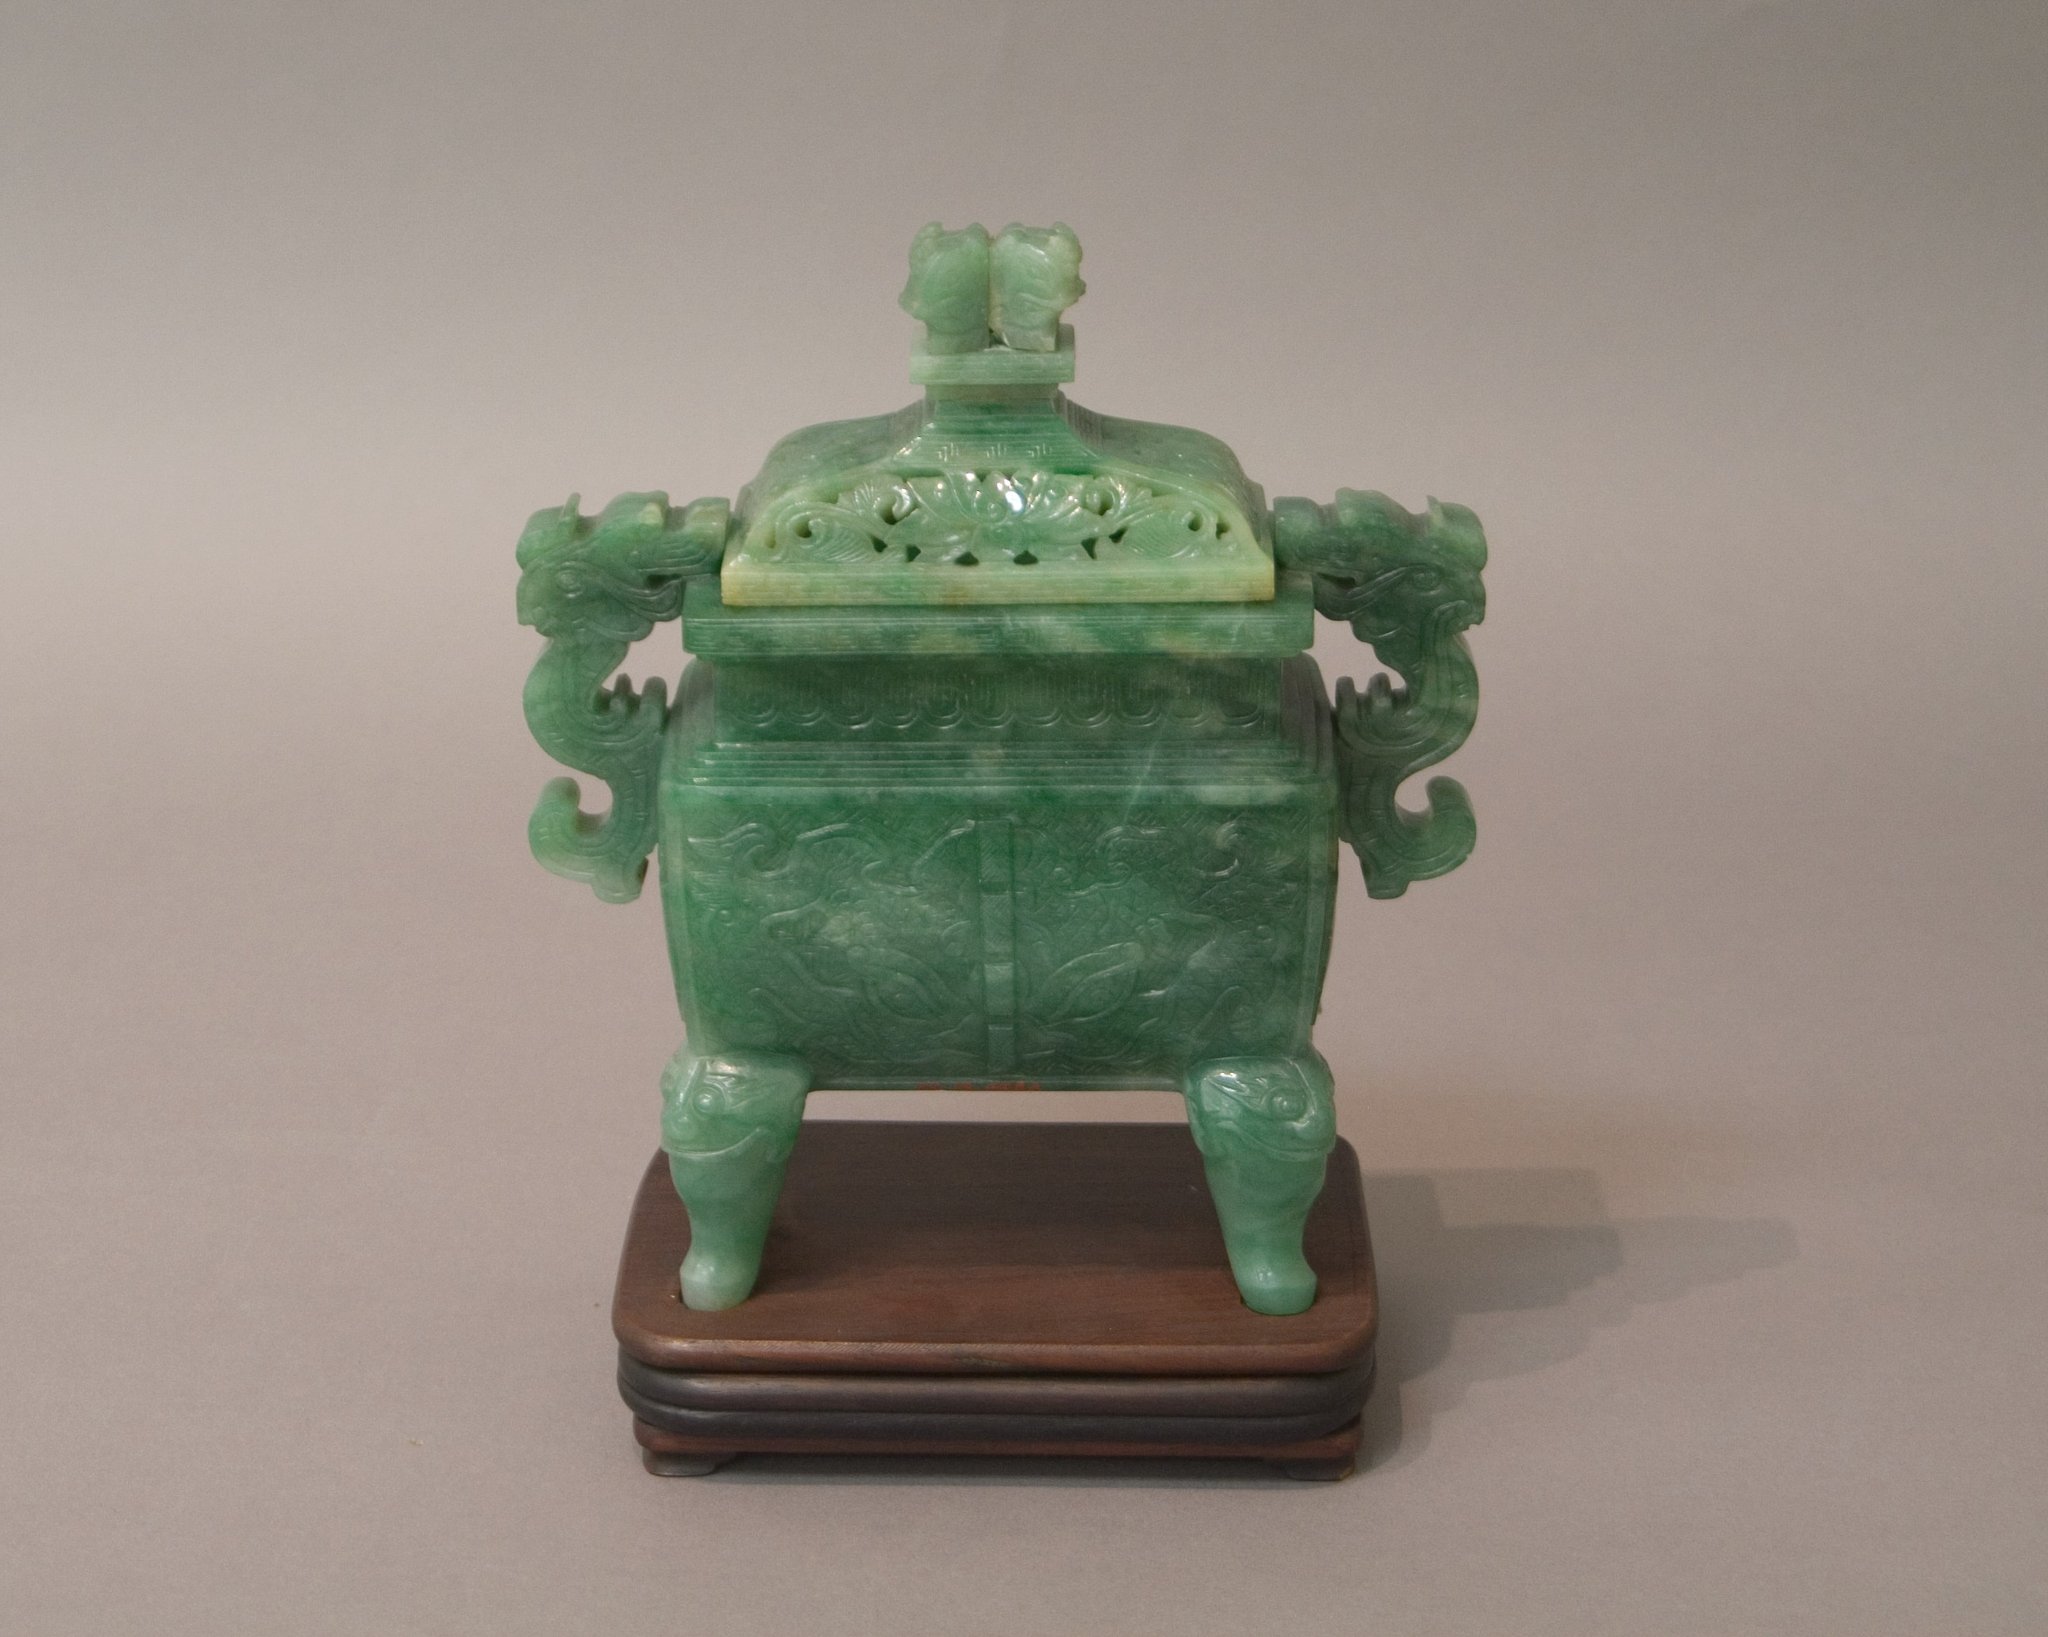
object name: incense burner with cover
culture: chinese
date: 1662-1722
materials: gemstone, jade